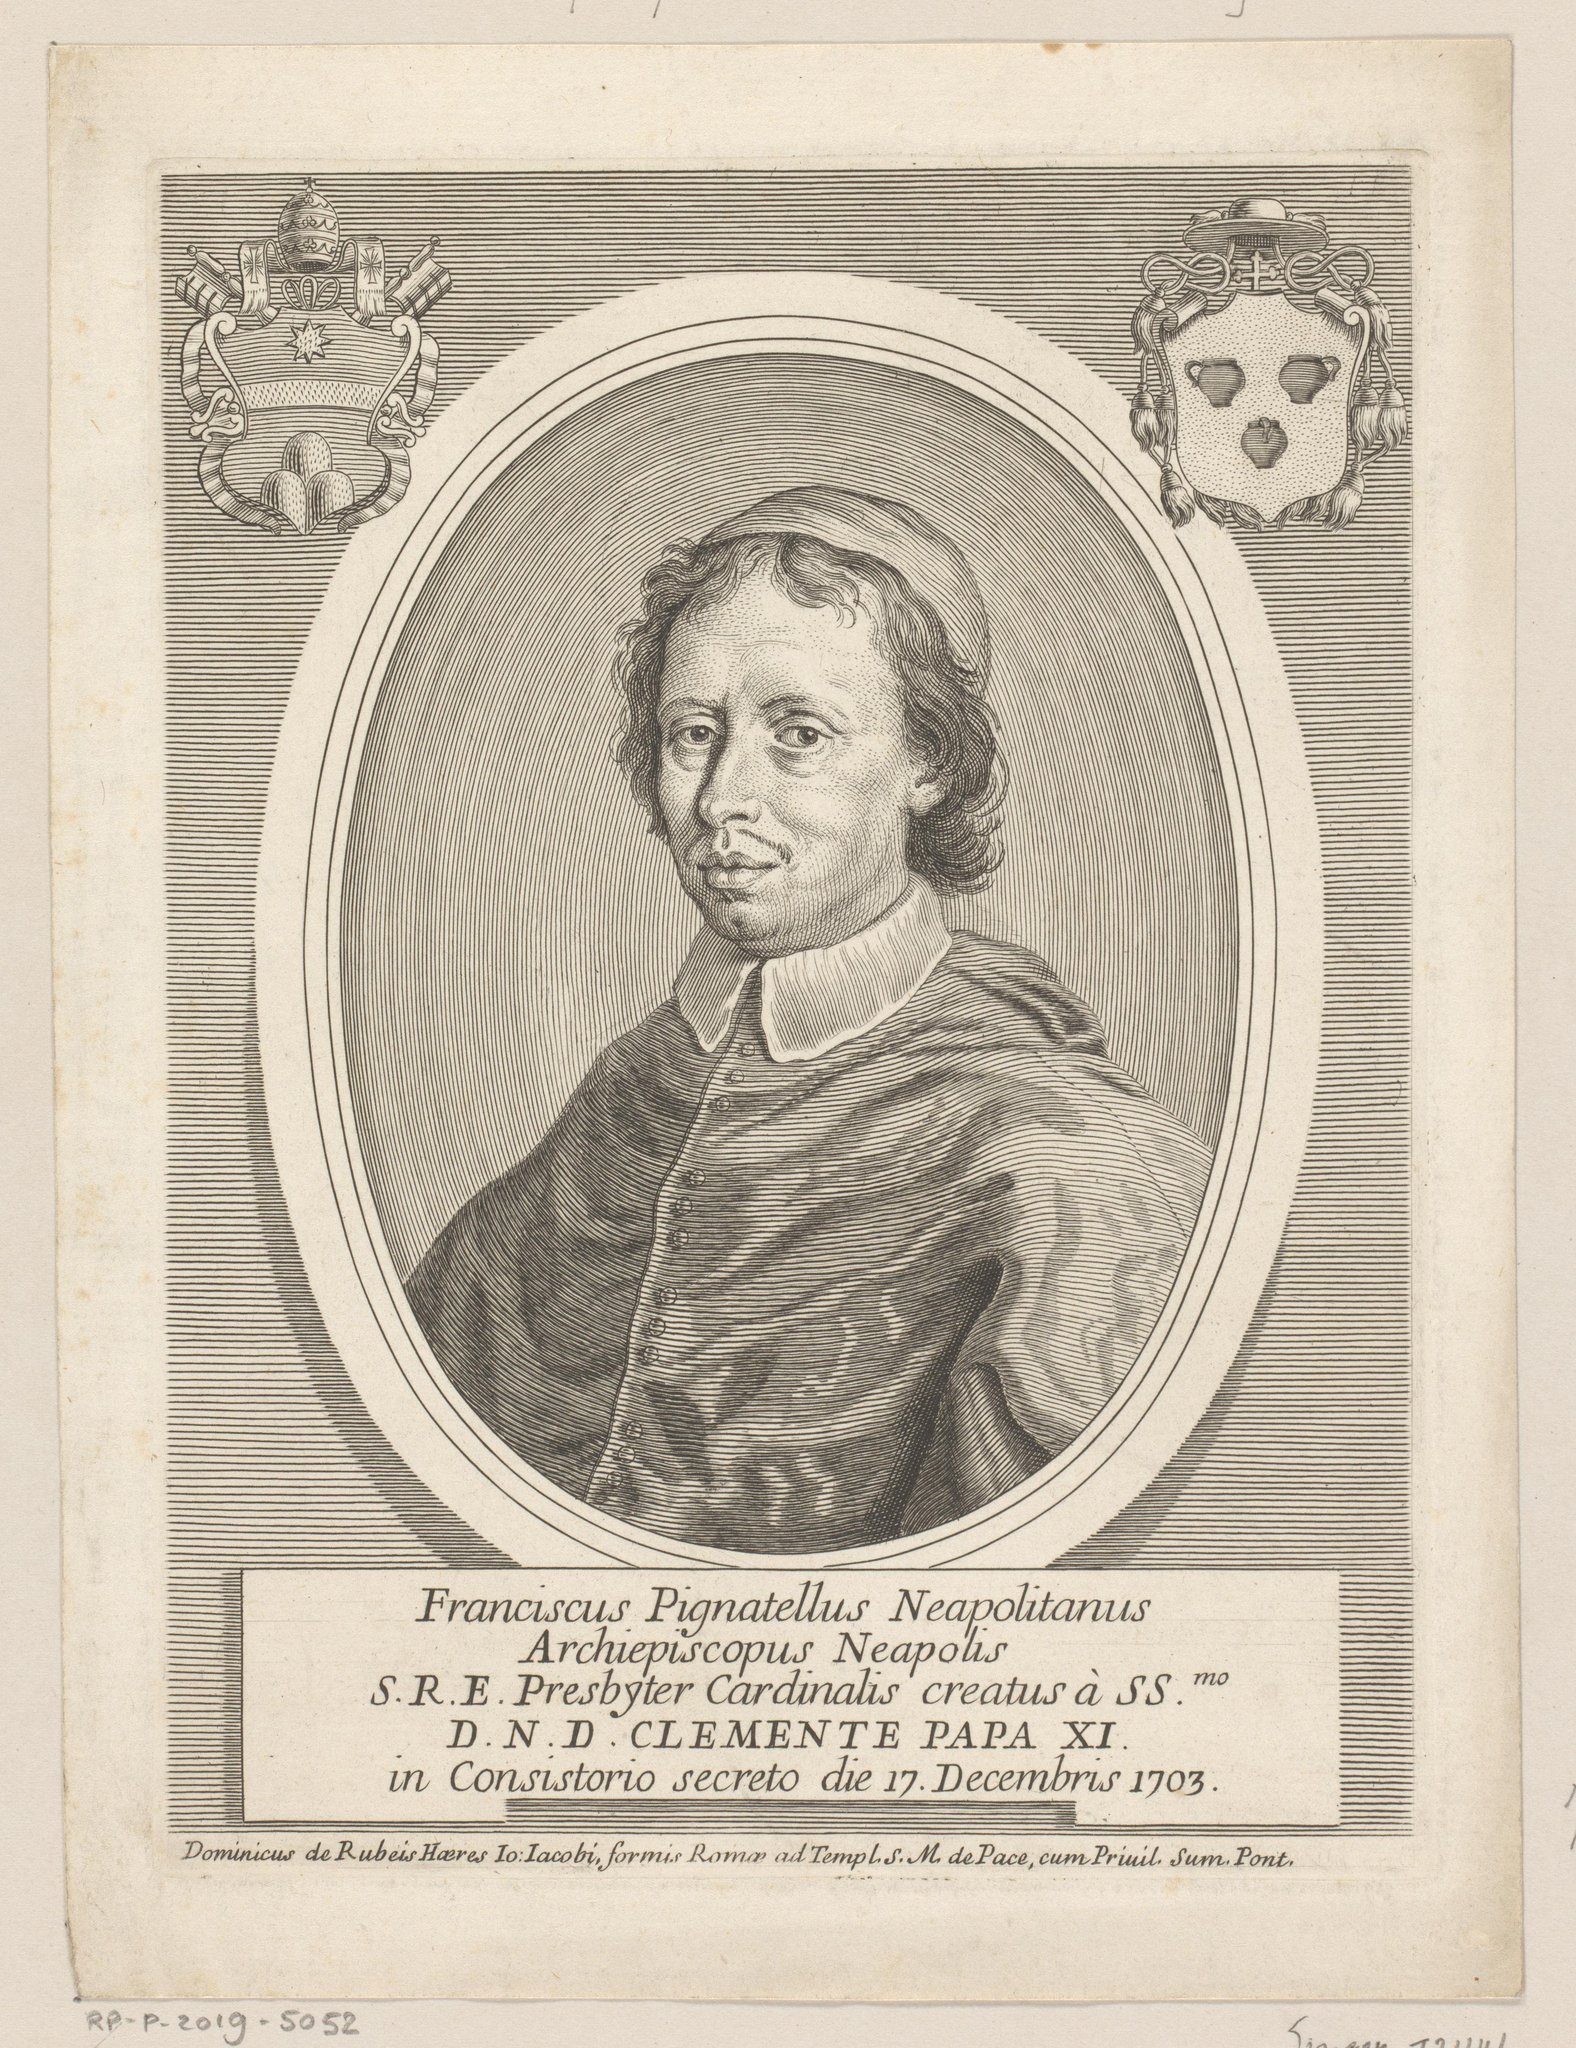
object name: print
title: Portretten van kardinalen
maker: Anonymous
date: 1703-1729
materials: paper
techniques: engraving, etching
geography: rome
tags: naples, cardinal, historical persons, armorial bearing, heraldry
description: Met rechtsboven zijn wapenschild en linksboven het wapen van paus Clemens XI.